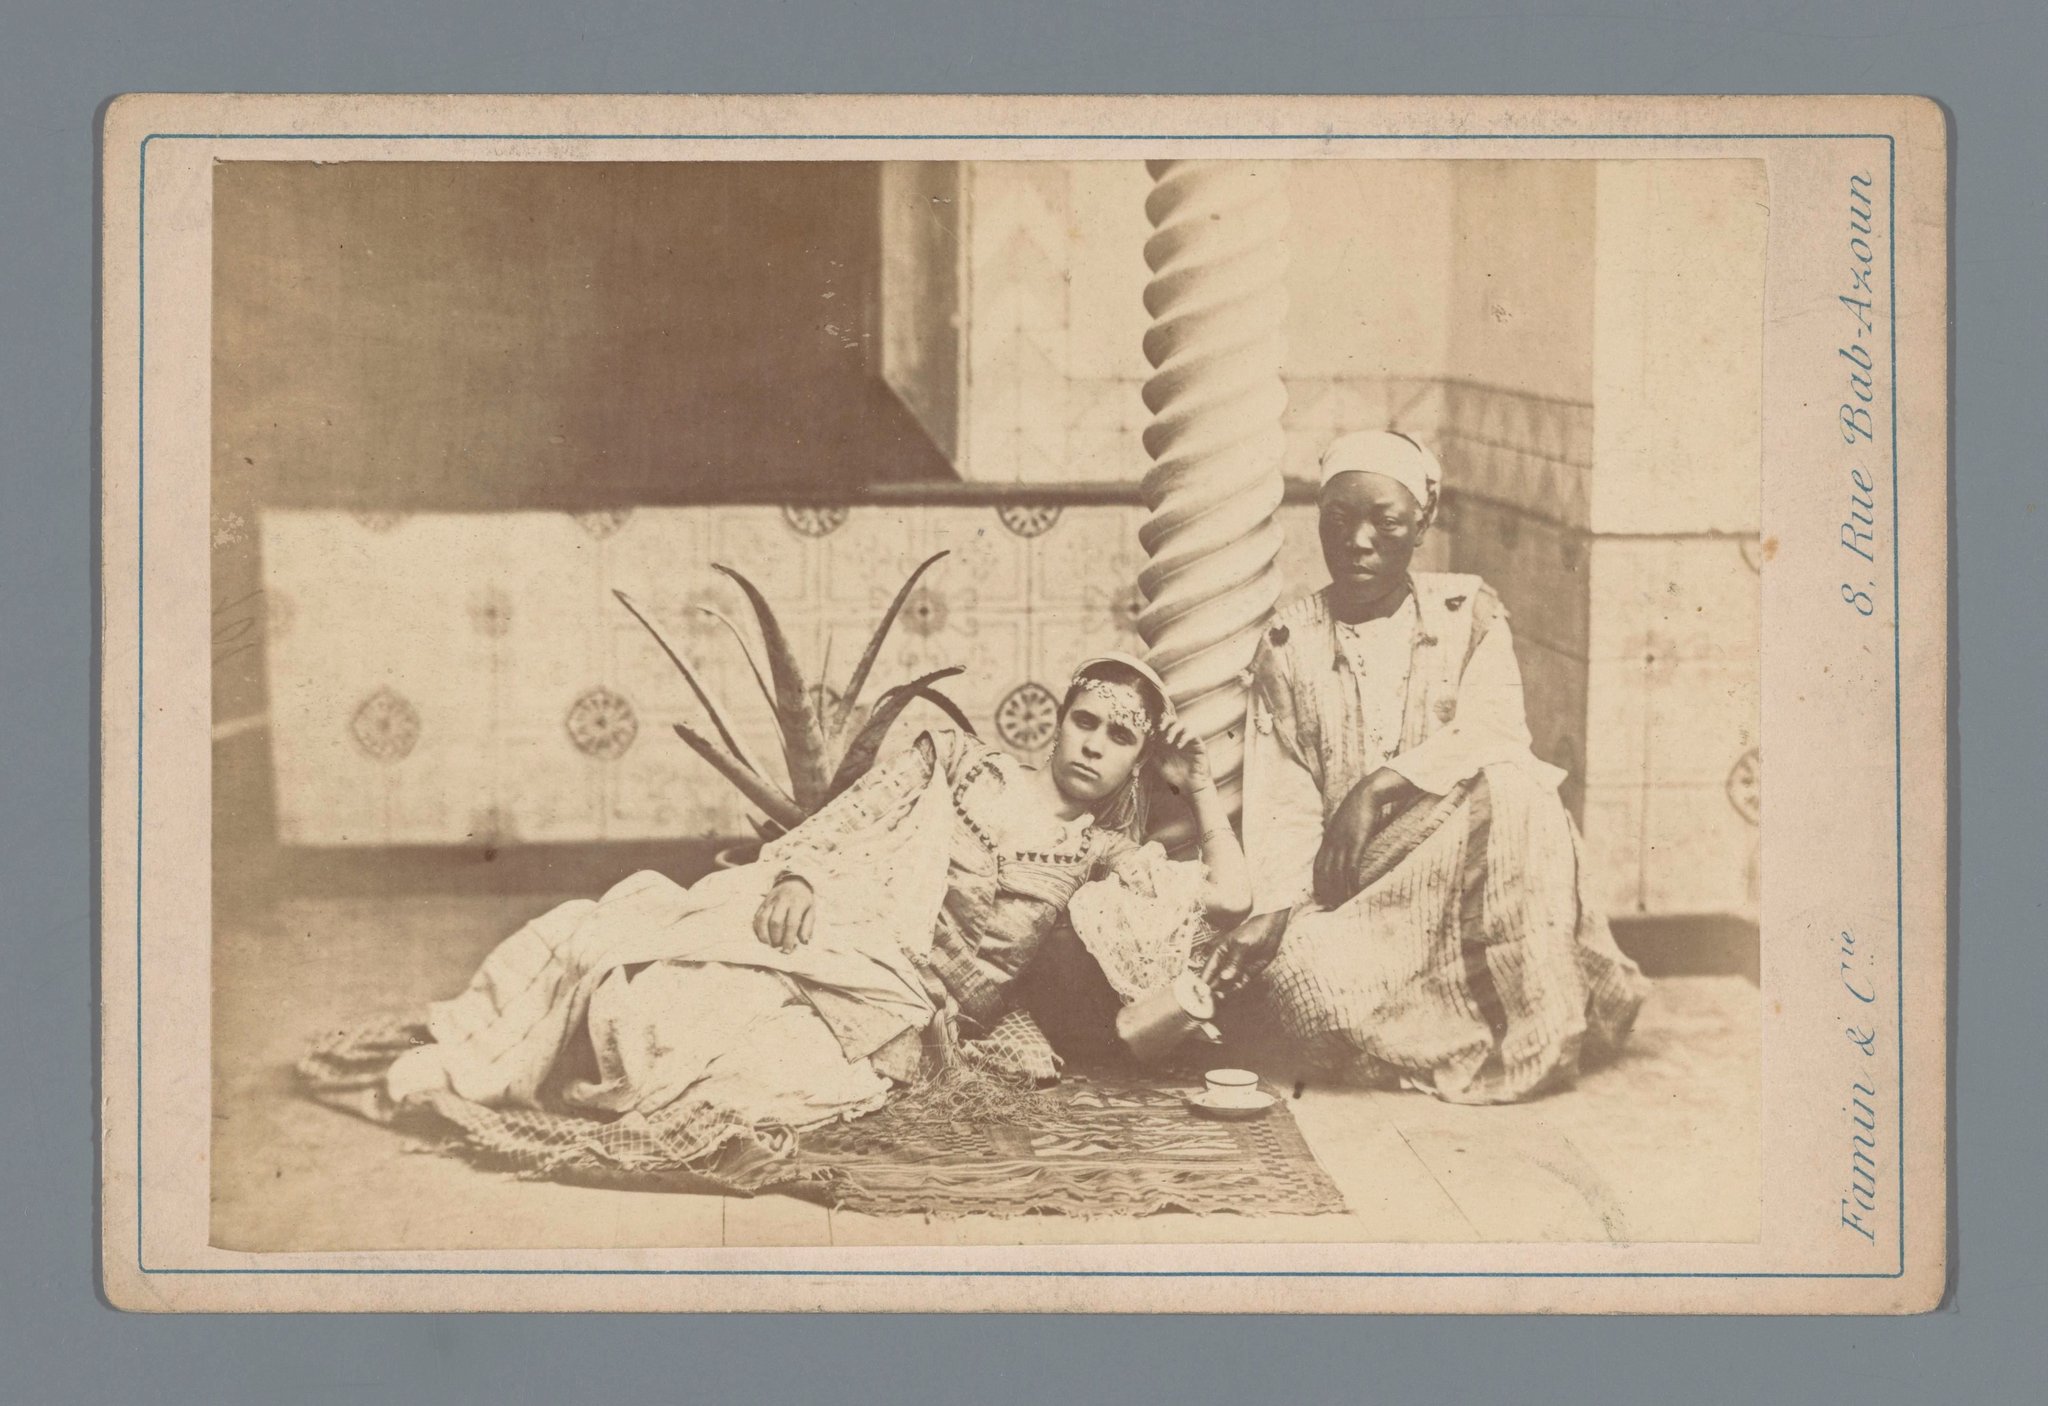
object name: cabinet photograph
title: Twee mensen in traditionele kledij bij zuil in Algerije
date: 1863-1889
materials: cardboard, photographic support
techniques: albumen print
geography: algeria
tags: afternoon tea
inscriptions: address: ‘8, Rue Bab-Azoun’, address: ‘Alger/ 8, Rue Bab-Azoun, 8.’, inscription: ‘Mauresque et sa negresse’